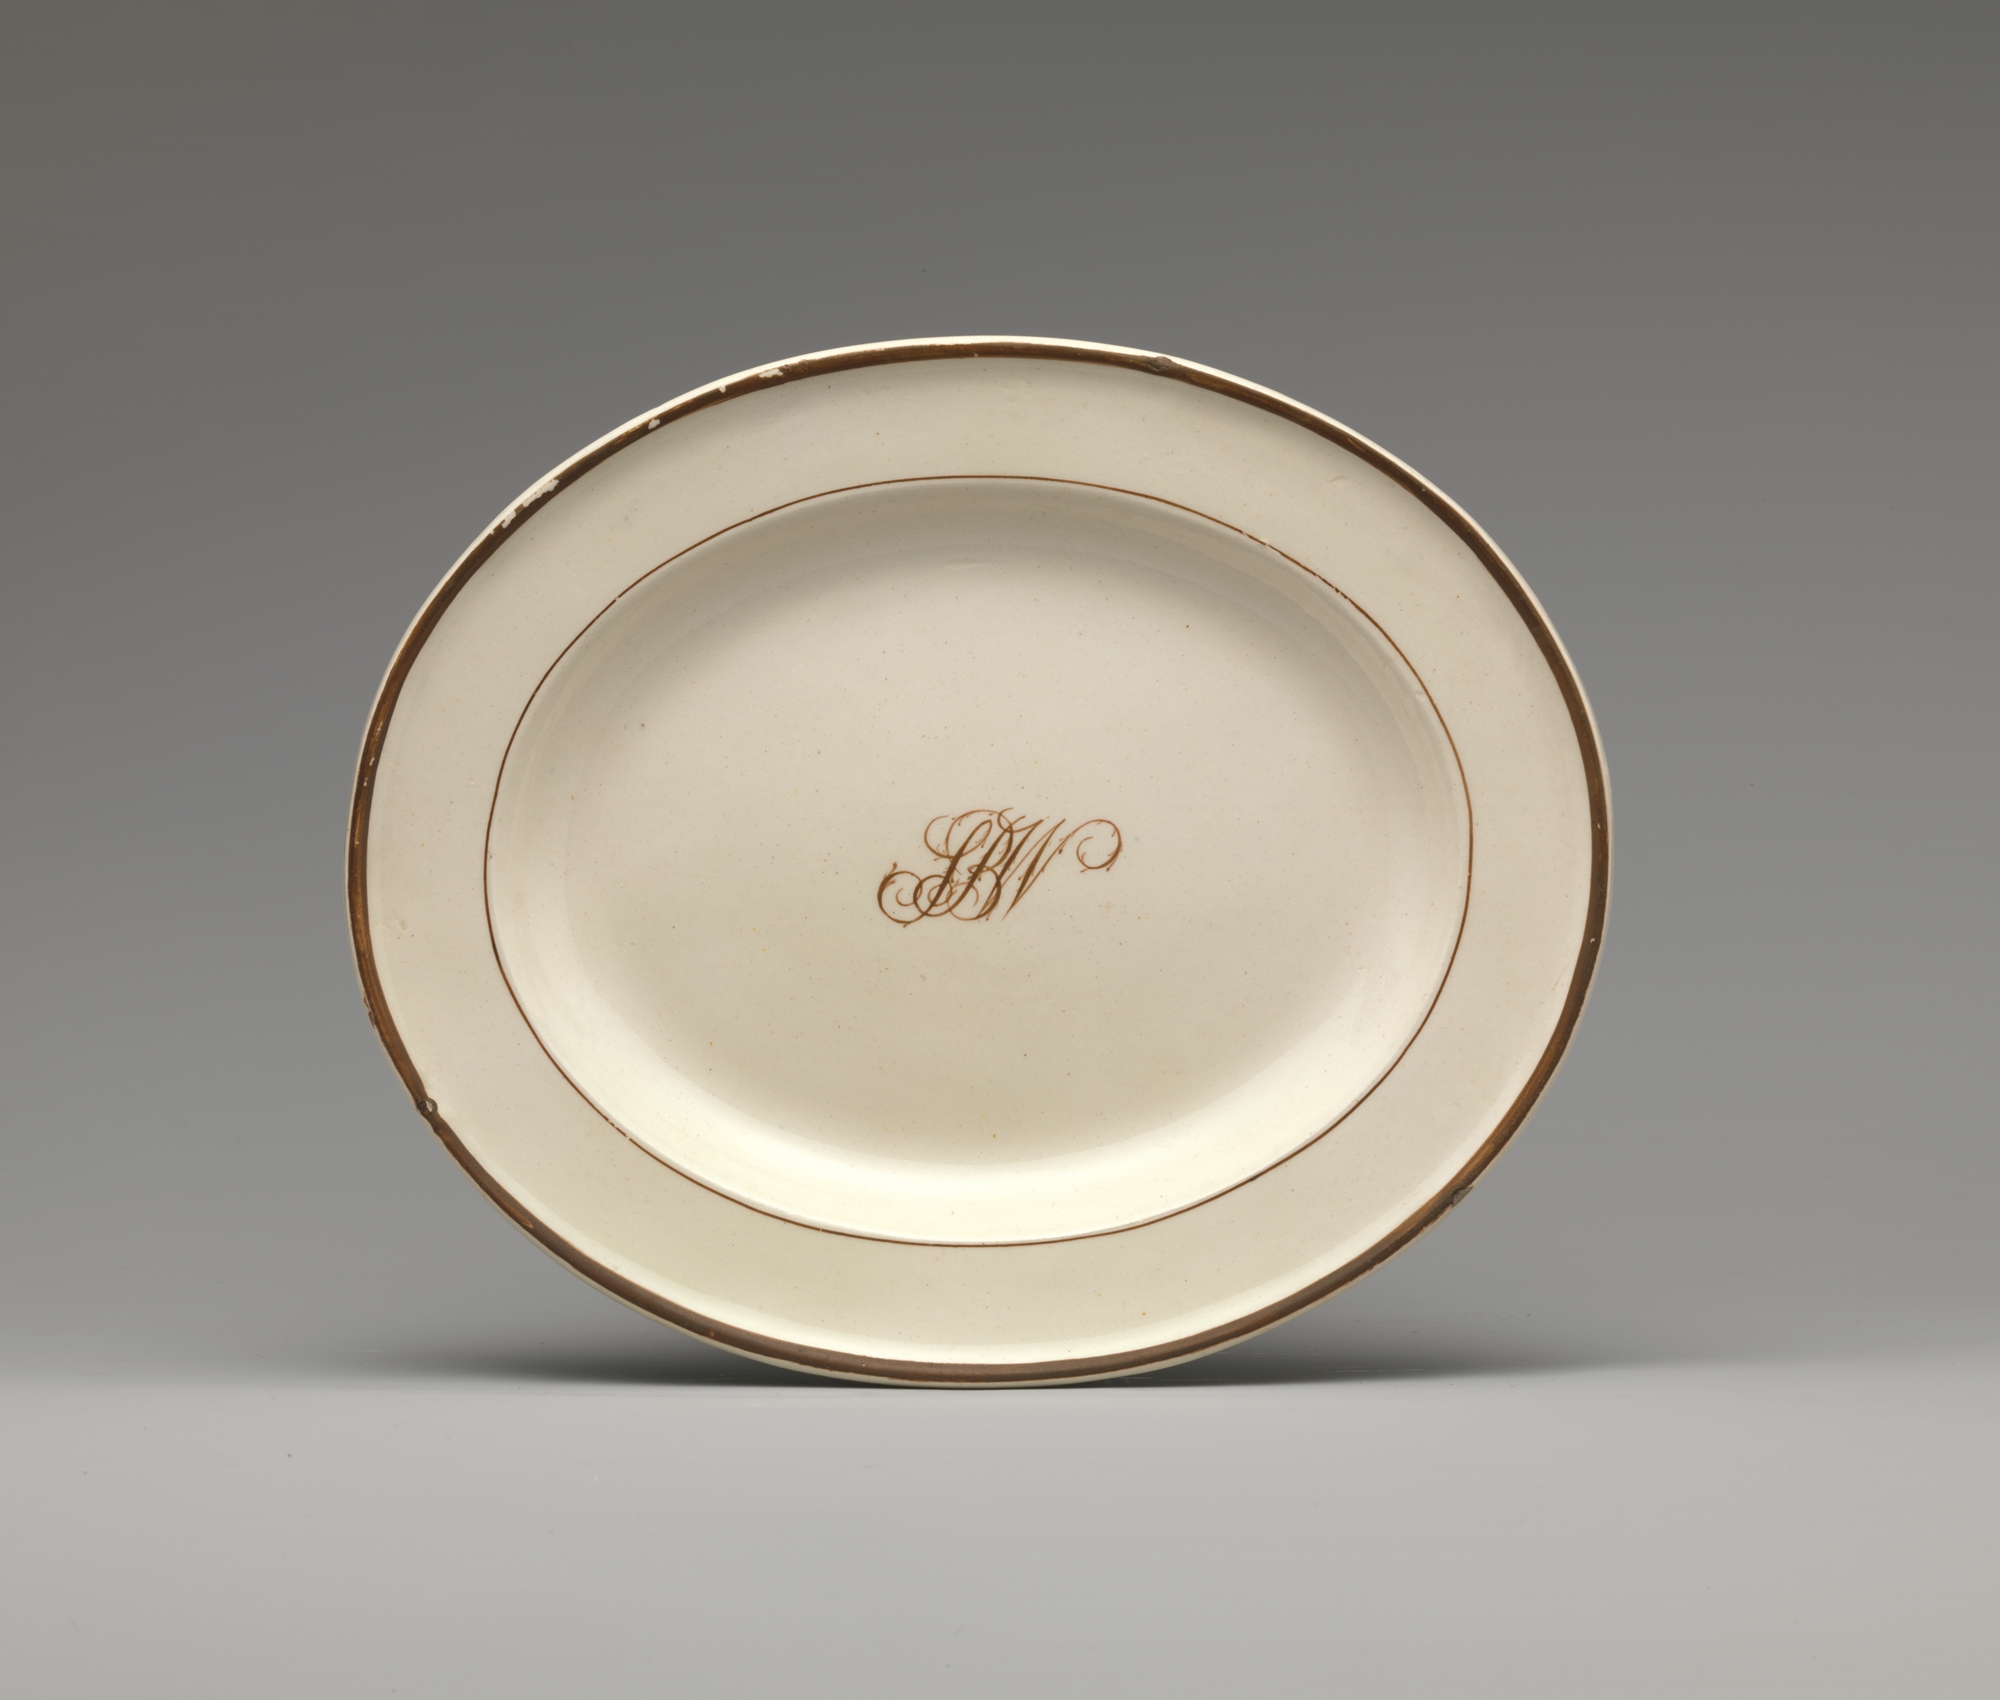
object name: dish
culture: british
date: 1750-1775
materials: earthenware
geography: england